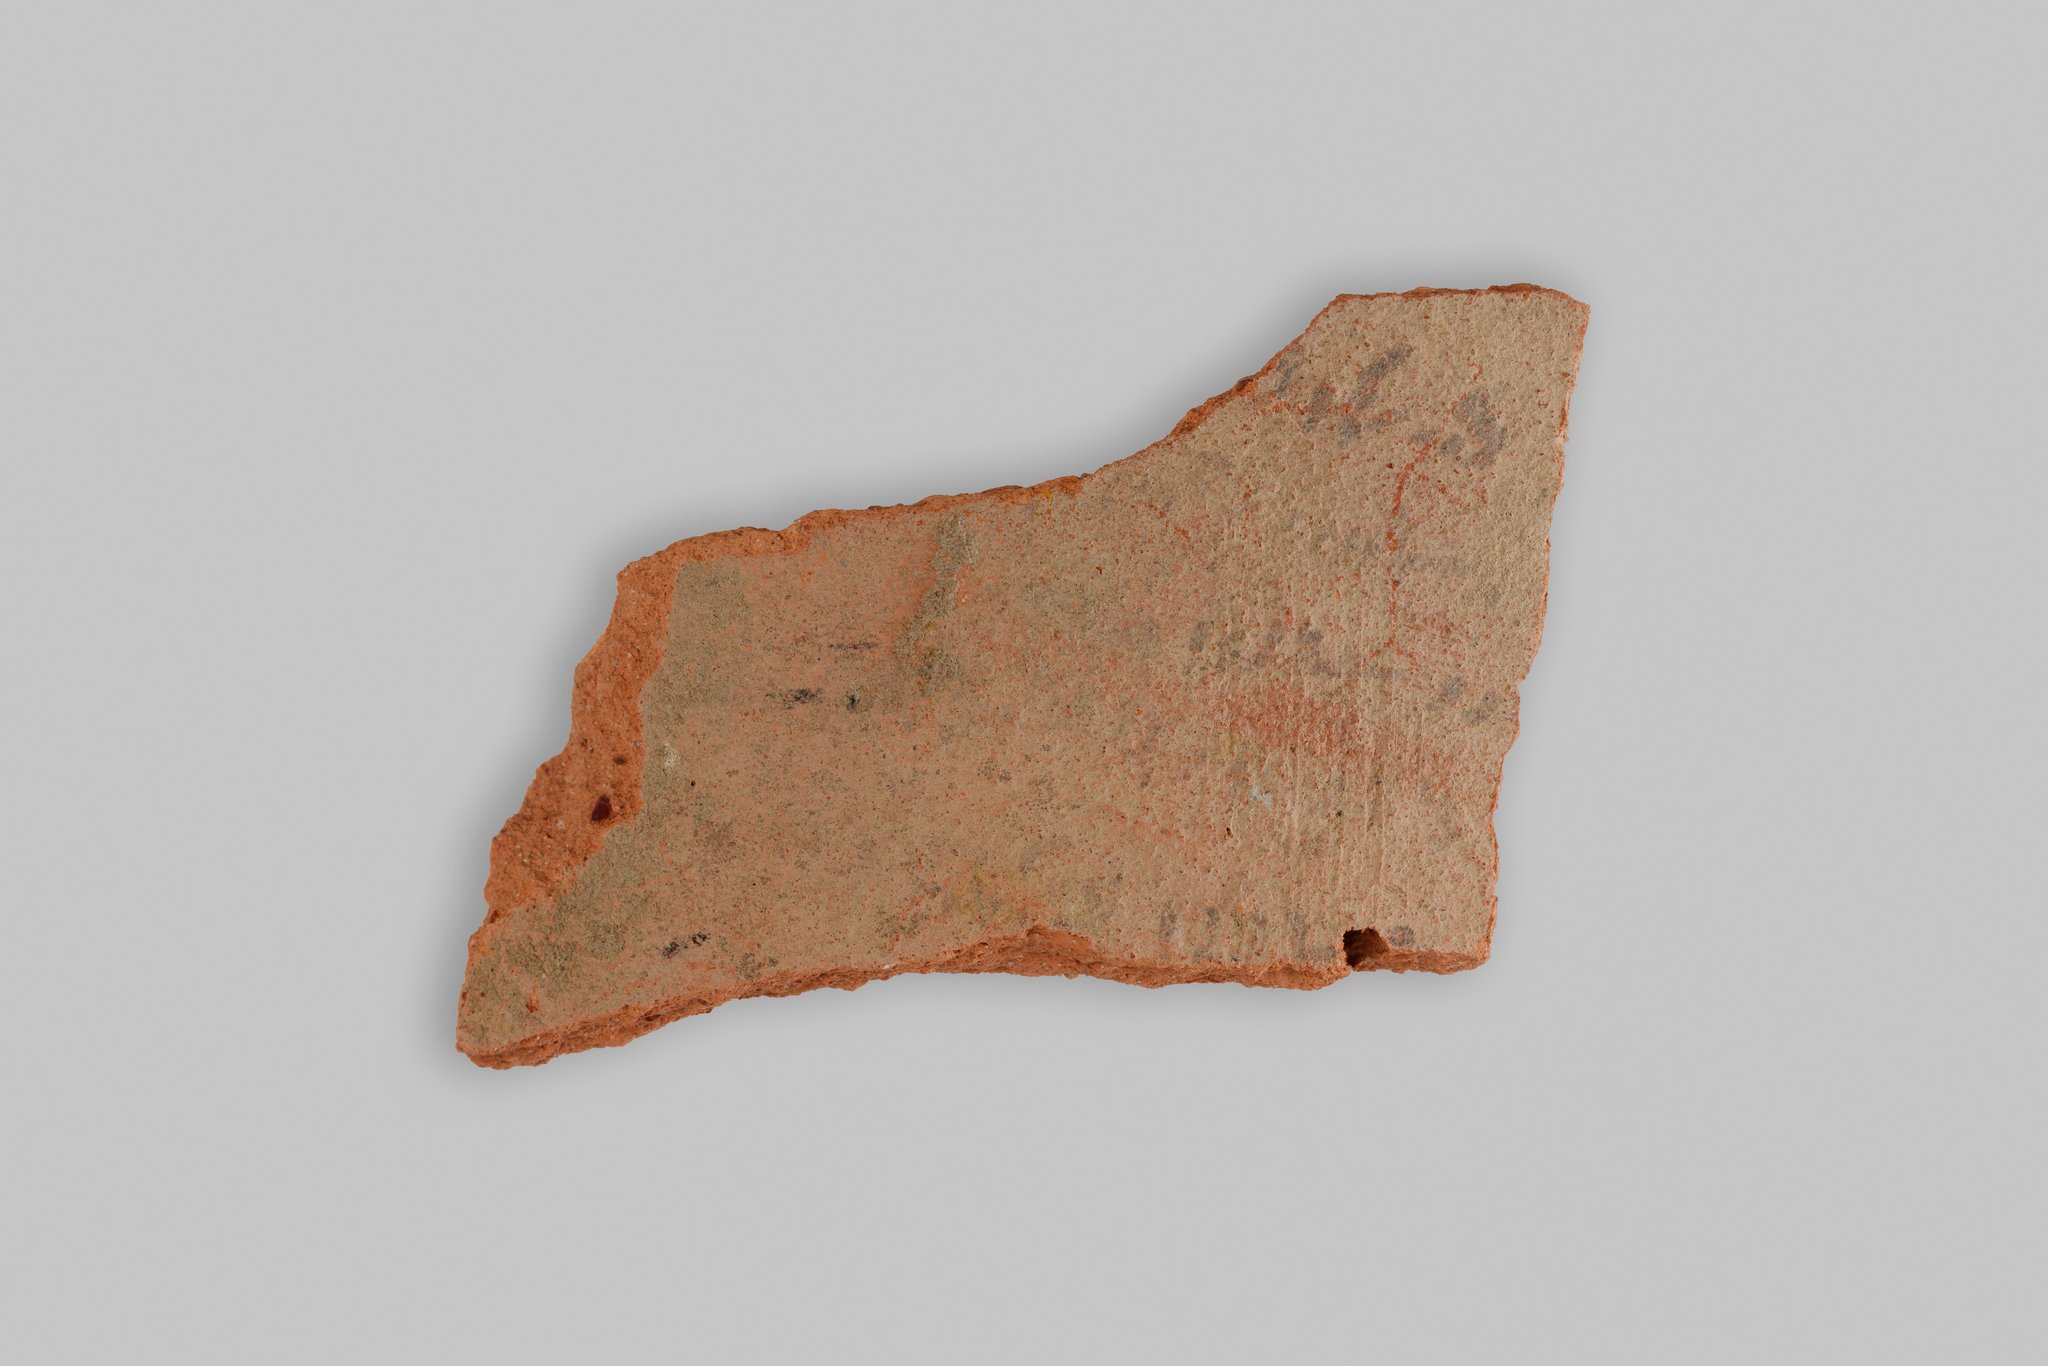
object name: ostracon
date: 400-30 BCE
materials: ink, pottery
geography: egypt